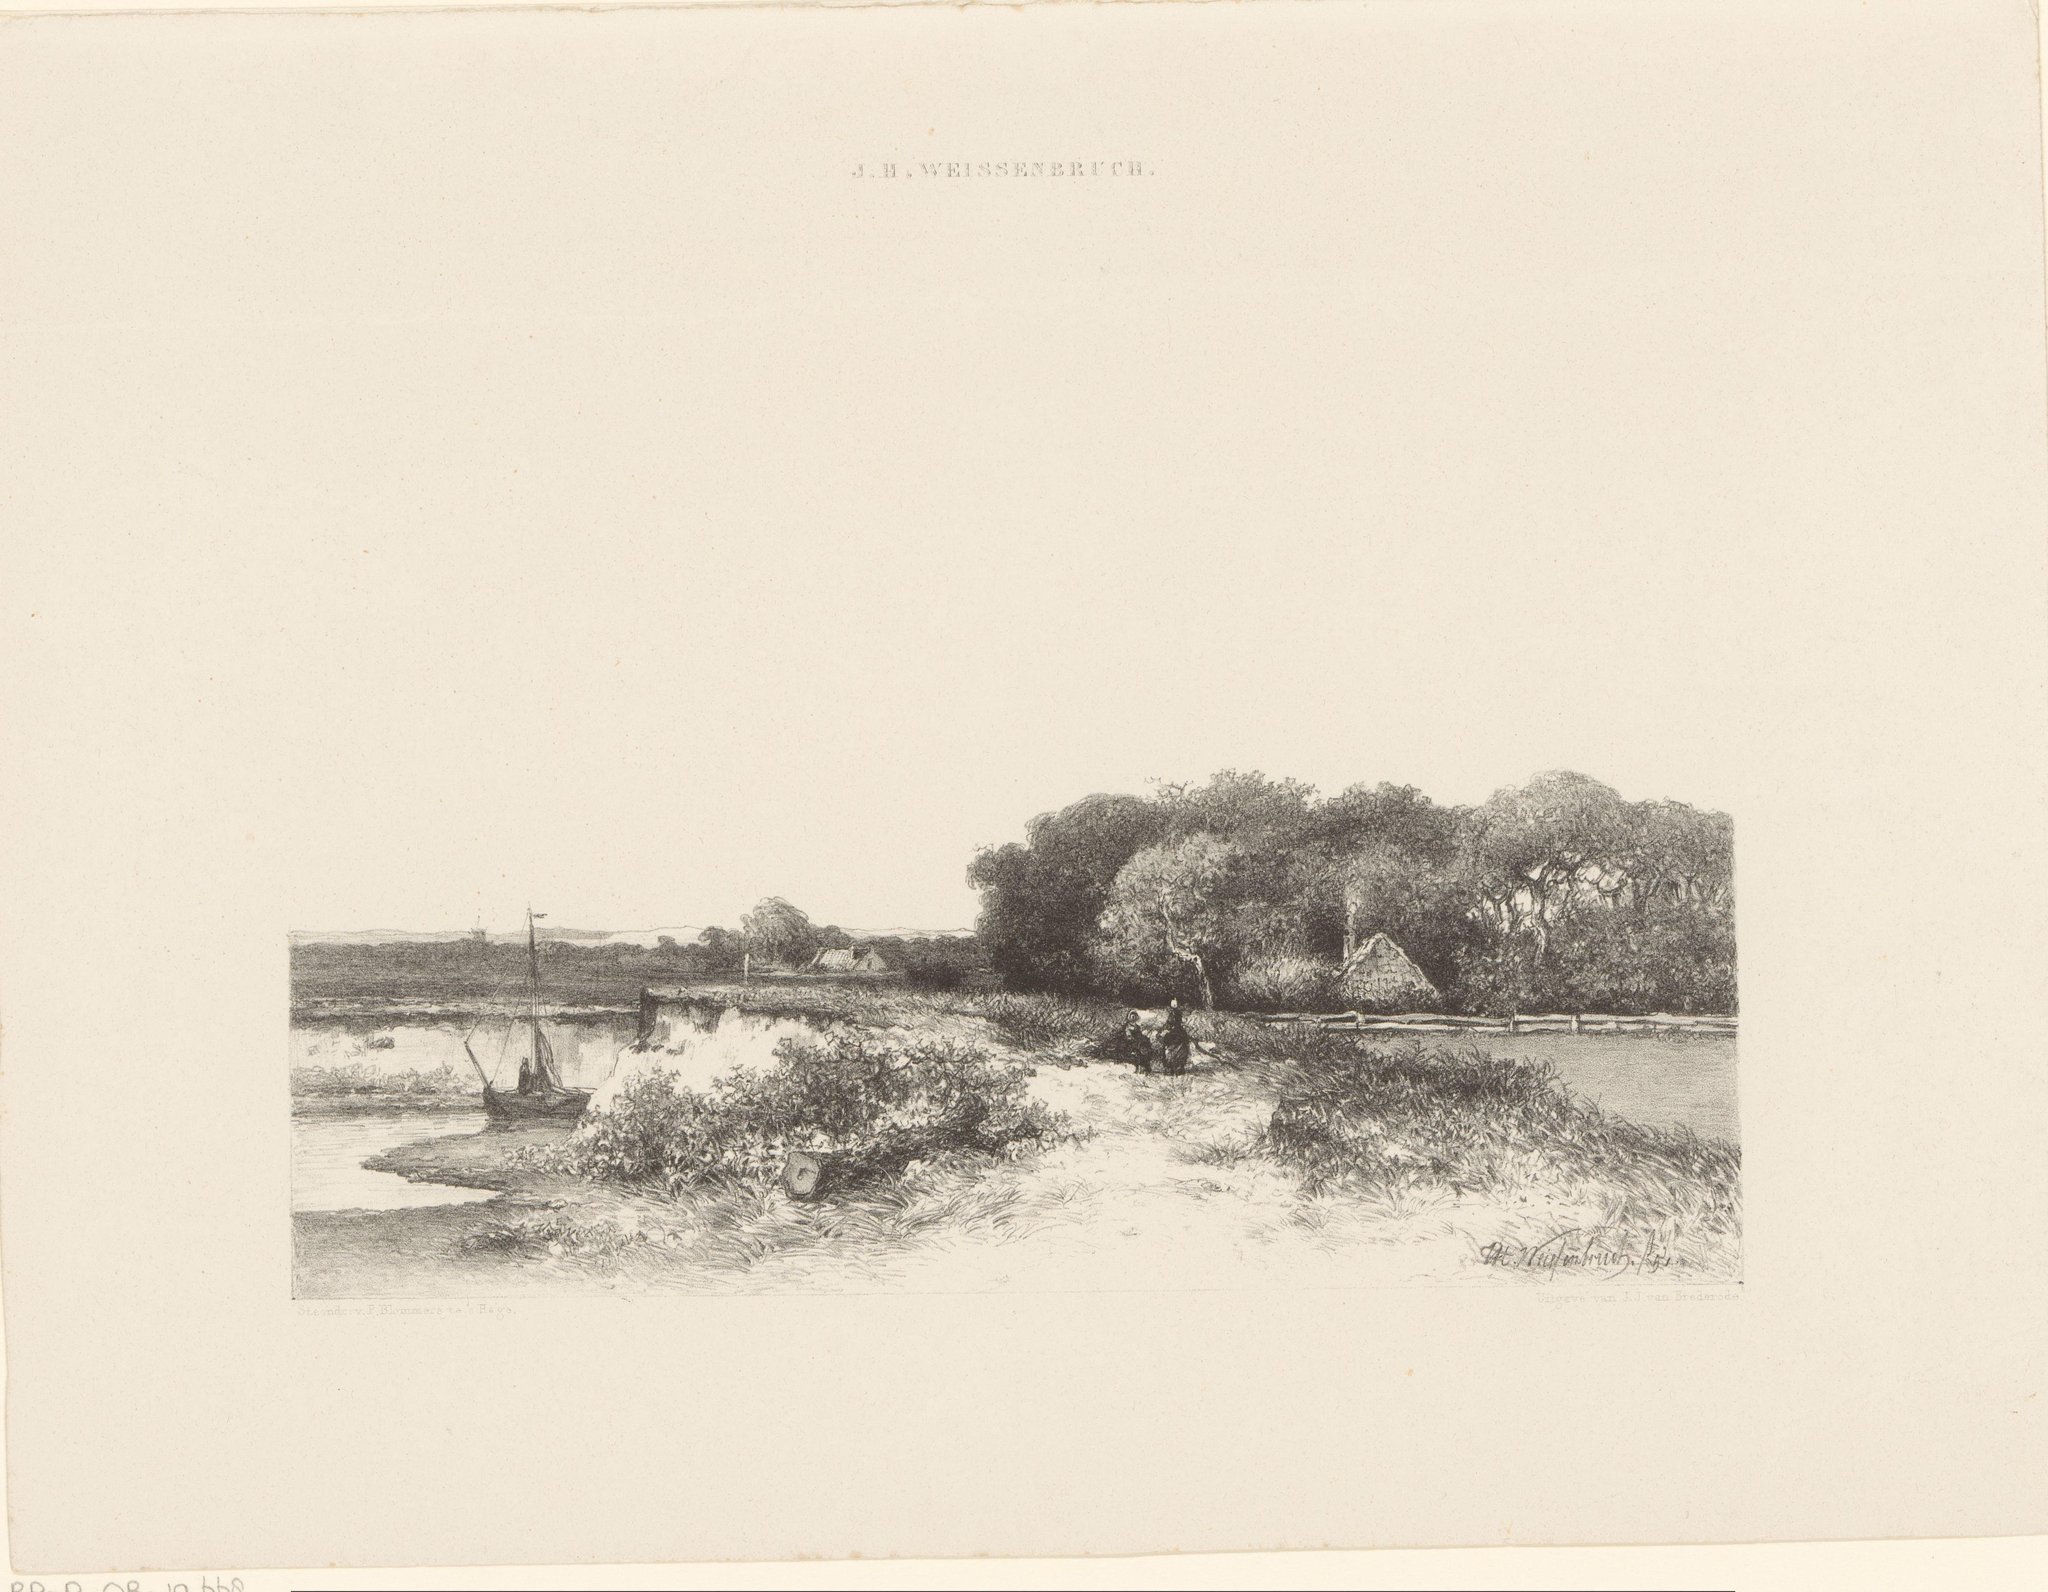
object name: print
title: Twee vrouwen in een landschap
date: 1851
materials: paper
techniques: lithograph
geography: the hague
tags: landscapes (+ landscape with figures, staffage)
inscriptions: collector's mark: Lugt 2228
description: Twee vrouwen in een landschap met links een zeilboot op het water en rechts in de achtergrond een boerderij.